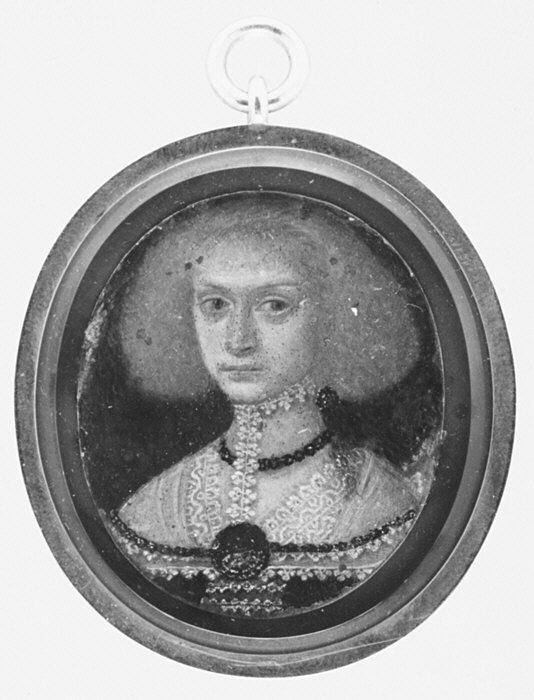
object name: painting, miniature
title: Portrait of a Woman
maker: continental painter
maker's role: artist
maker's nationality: continental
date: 1625-1635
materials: metal, oil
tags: portraits,women